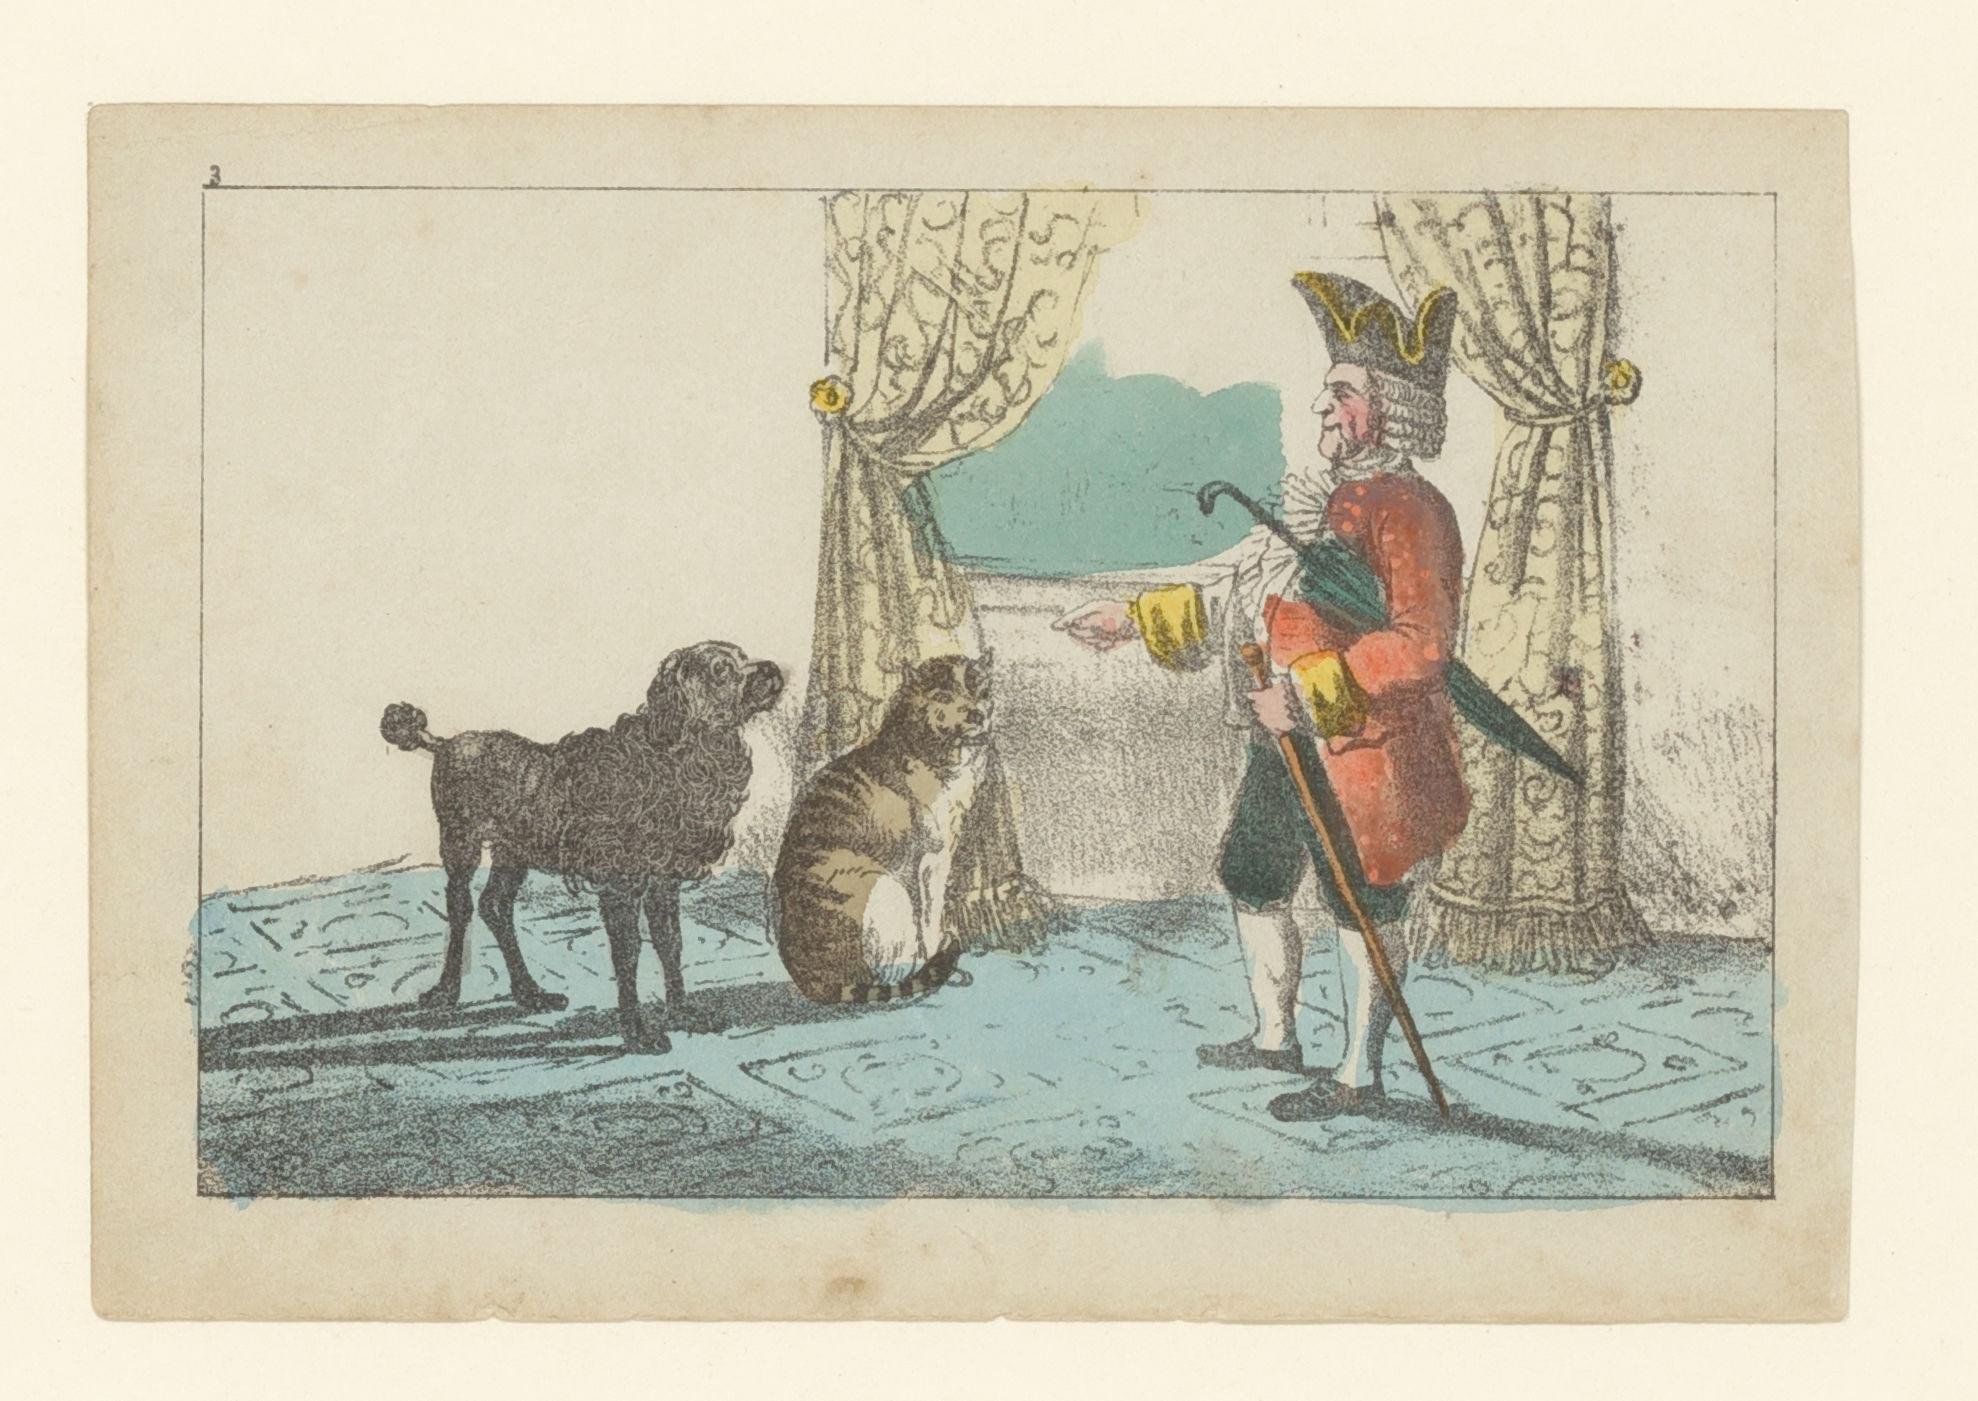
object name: print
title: Kardoes en Muizenschik toegesproken door hun baas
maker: Anonymous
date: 1841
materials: paper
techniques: hand coloring, lithograph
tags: cat, evening meal, dinner, supper, dog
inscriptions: stamp, collector's mark: Lugt 1641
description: Linksboven genummerd: 3. Onderwerpsrubrieken binnen de Atlas Zeden en Gewoonten: Zeden en Gewoonten in Engeren Zin, Des menschen beging, midden en einde, Kinderleven – Kinderspel en Kinderprenten.